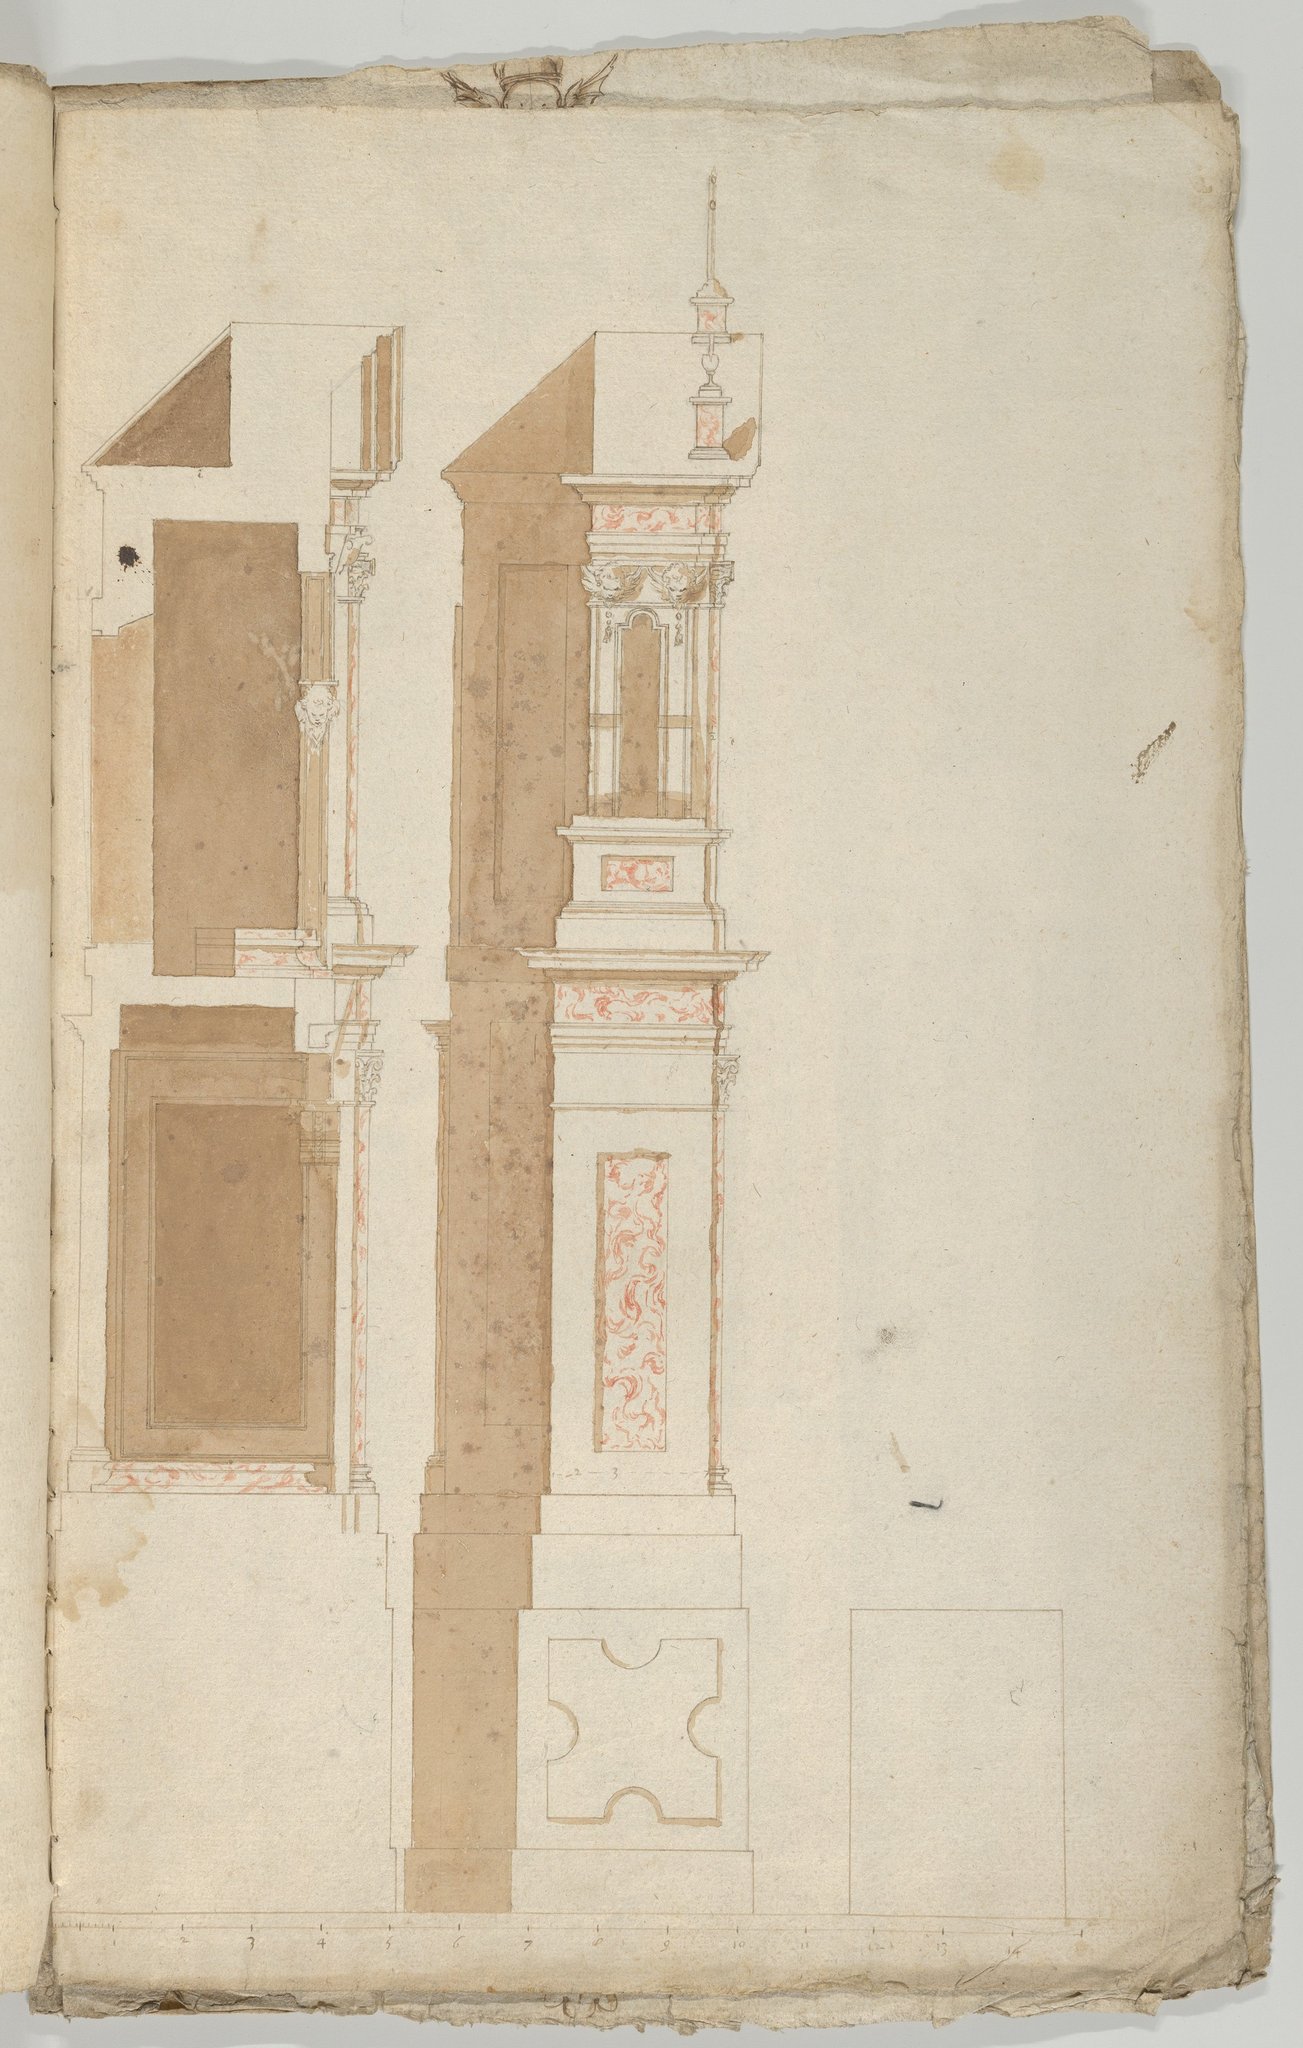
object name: drawing ornament architecture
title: Side view of an Altar with Red Marble to be set against a Wall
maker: anonymous, flemish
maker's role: artist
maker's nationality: flemish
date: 1601-1700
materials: ink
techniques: pen, wash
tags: altars